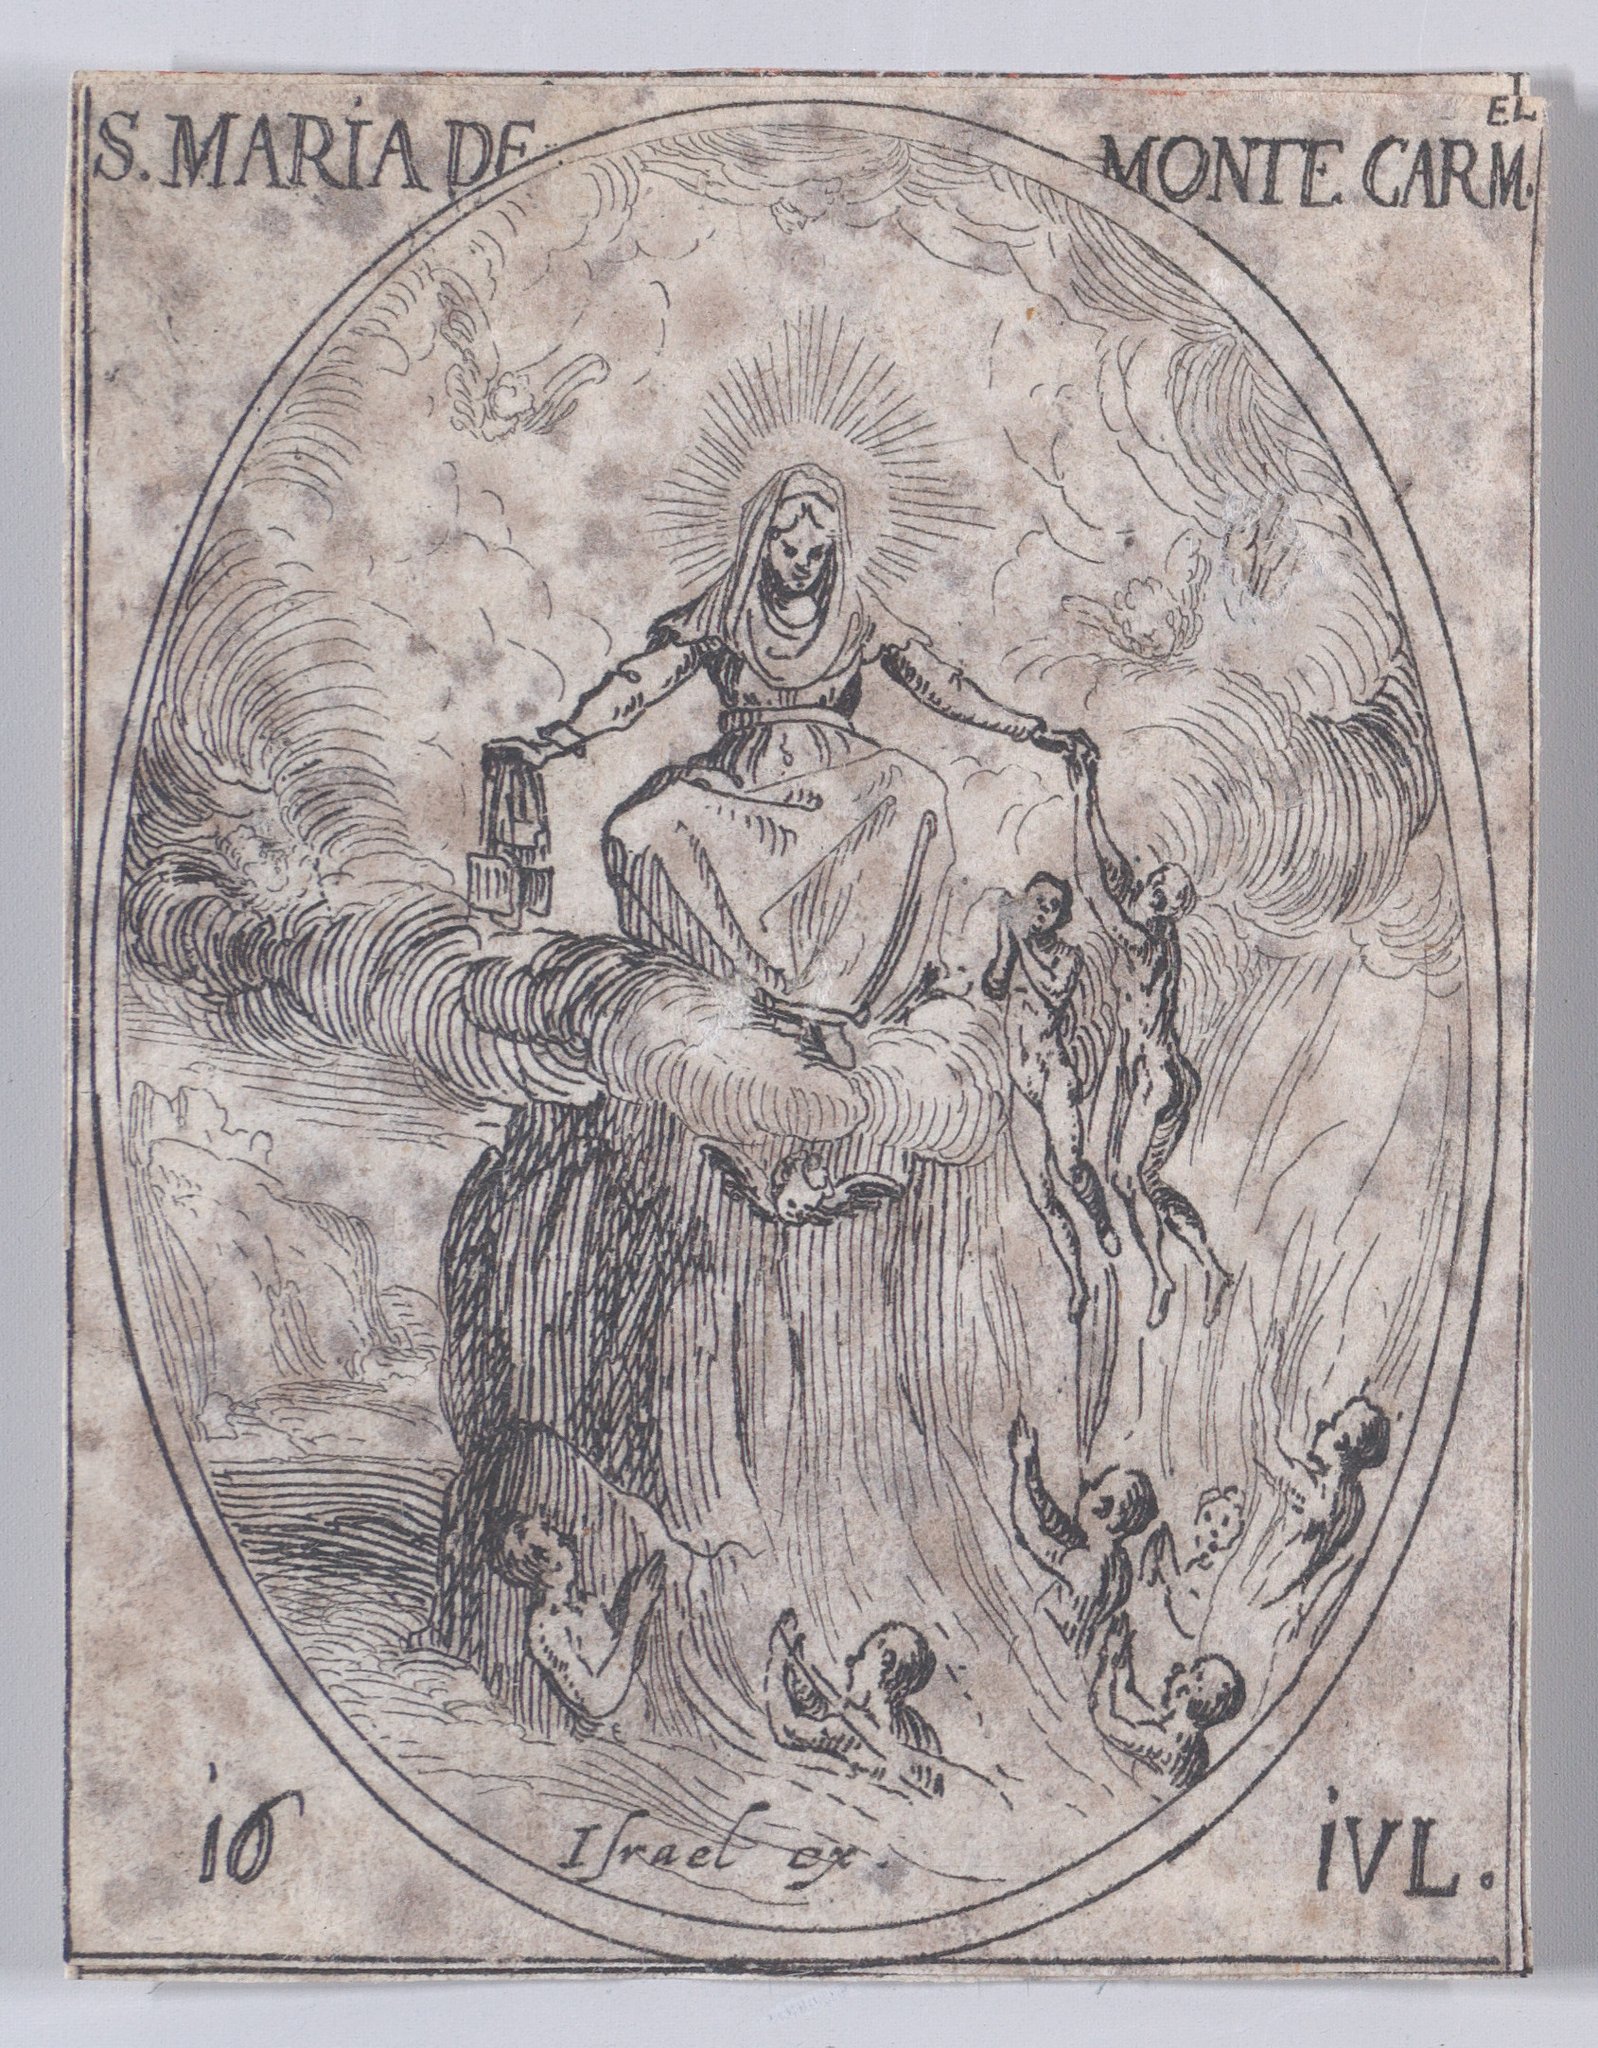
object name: print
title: Ste. Marie du Mont Carmel (Feast of Virgin Mary of Mount Carmel), July 16th, from "Les Images De Tous Les Saincts et Saintes de L'Année" (Images of All of the Saints and Religious Events of the Year)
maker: jacques callot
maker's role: artist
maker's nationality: french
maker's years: 1592-1635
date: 1636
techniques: etching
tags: virgin mary